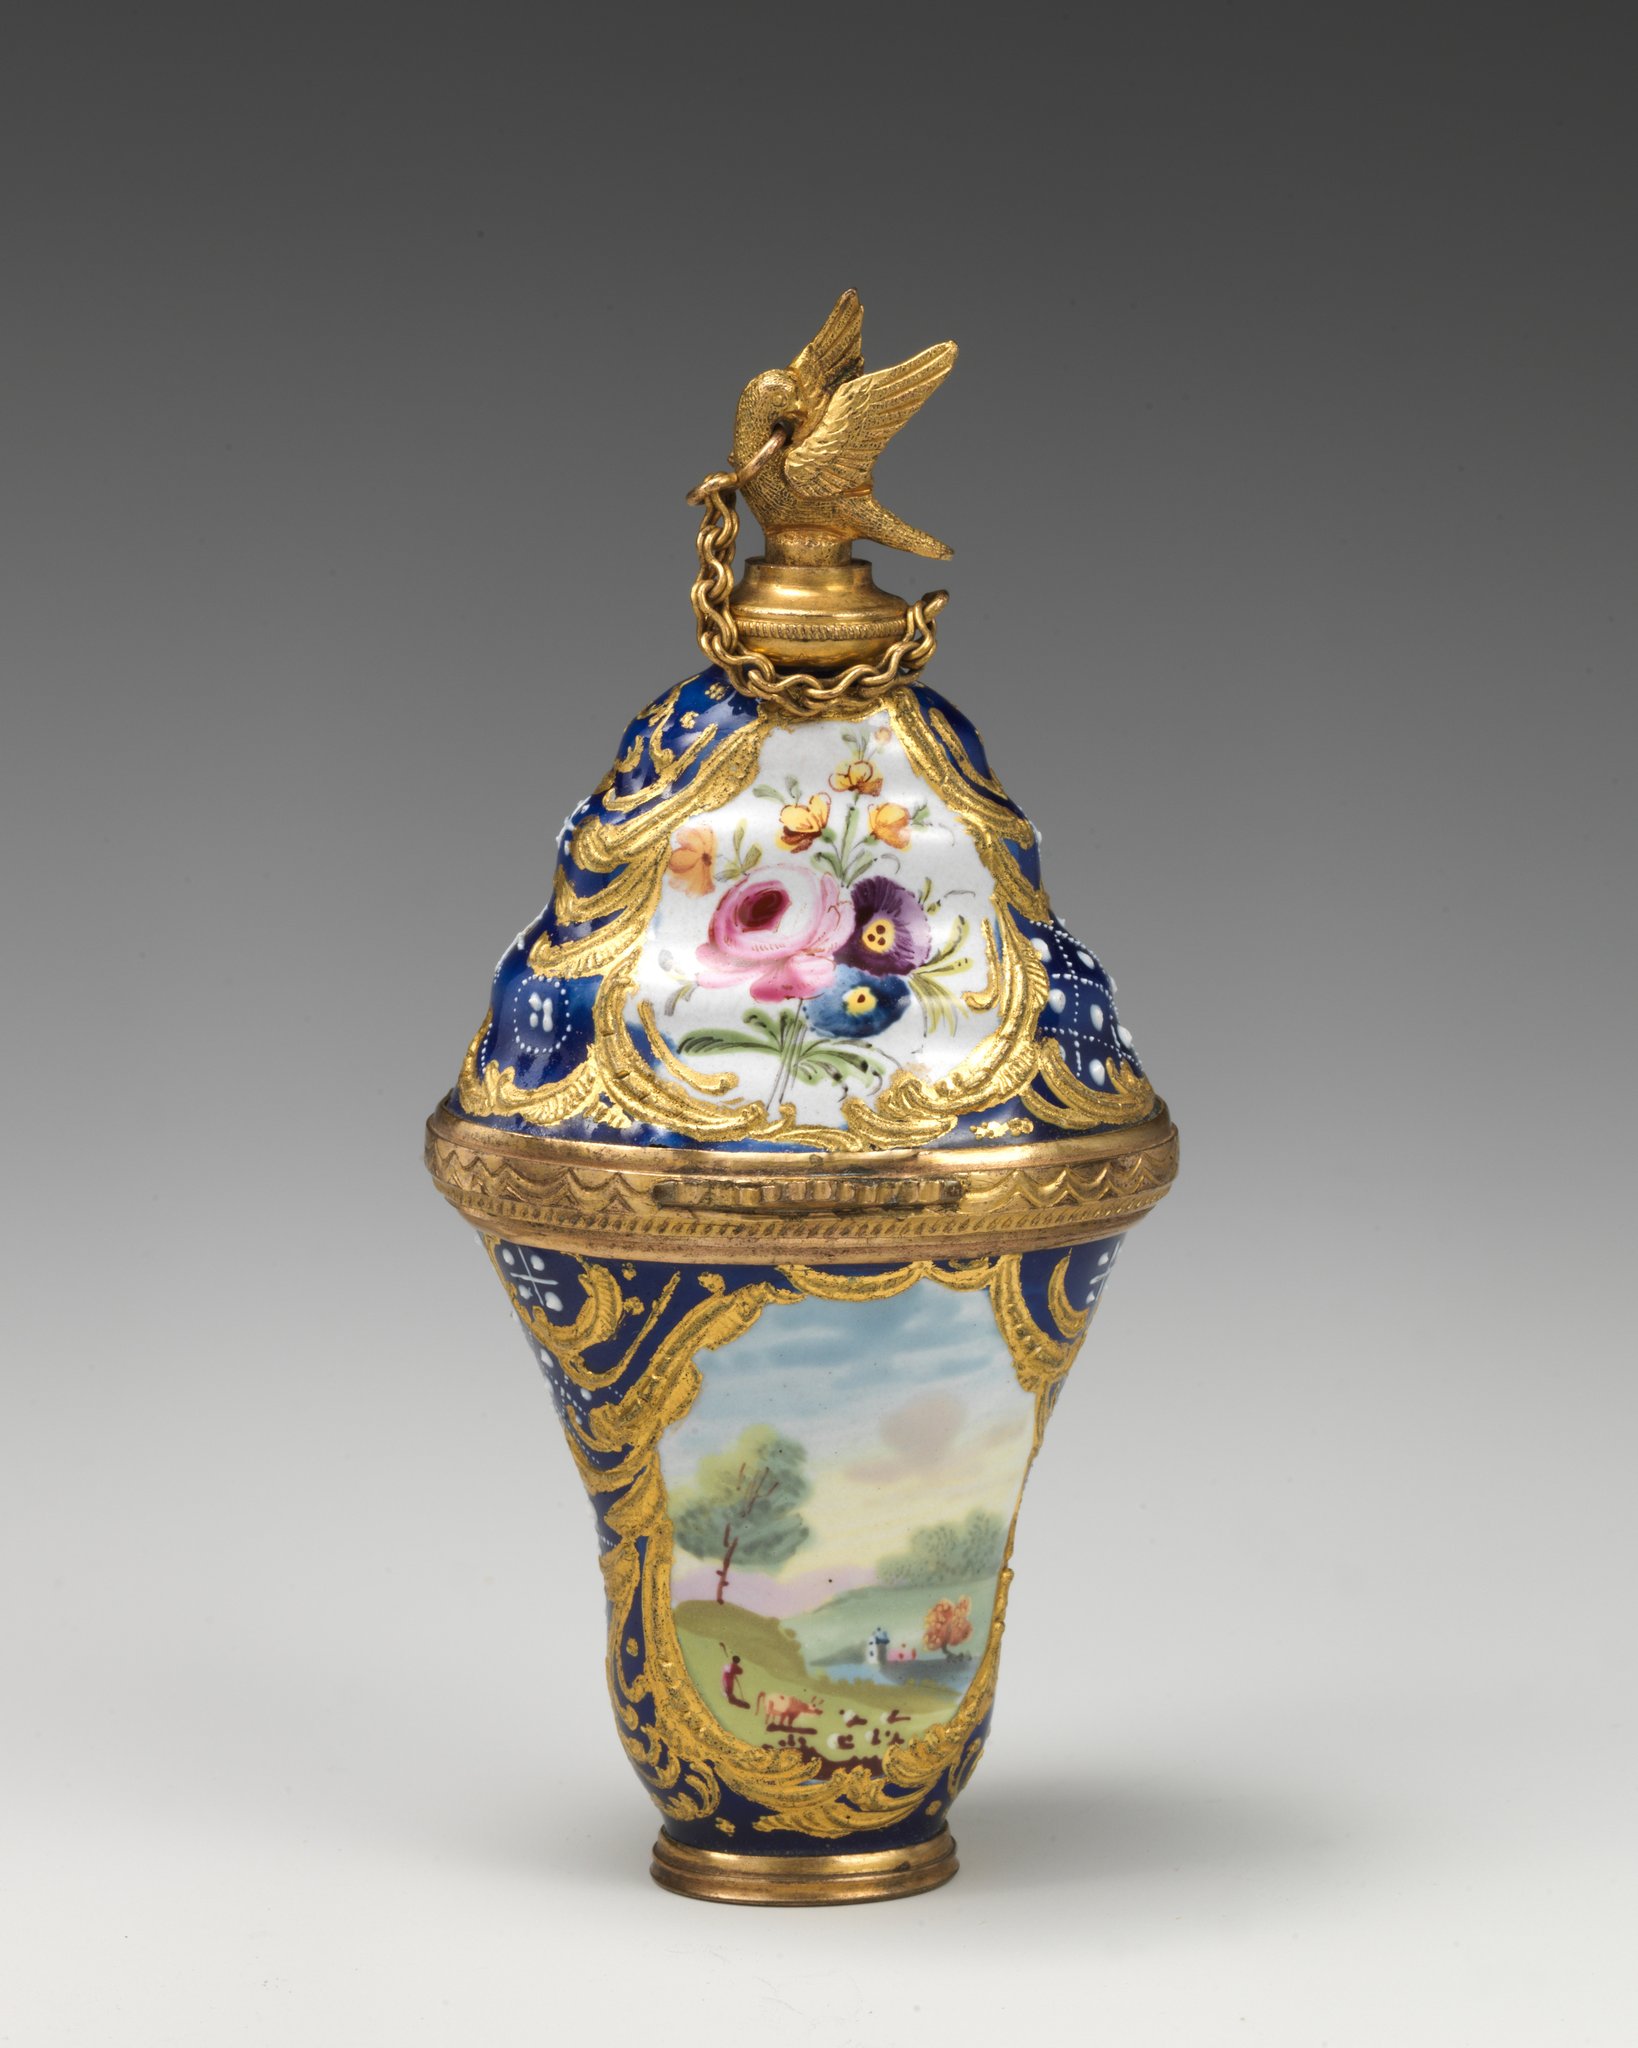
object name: scent bottle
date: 1765-1770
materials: copper, enamel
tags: birds,flowers,landscapes